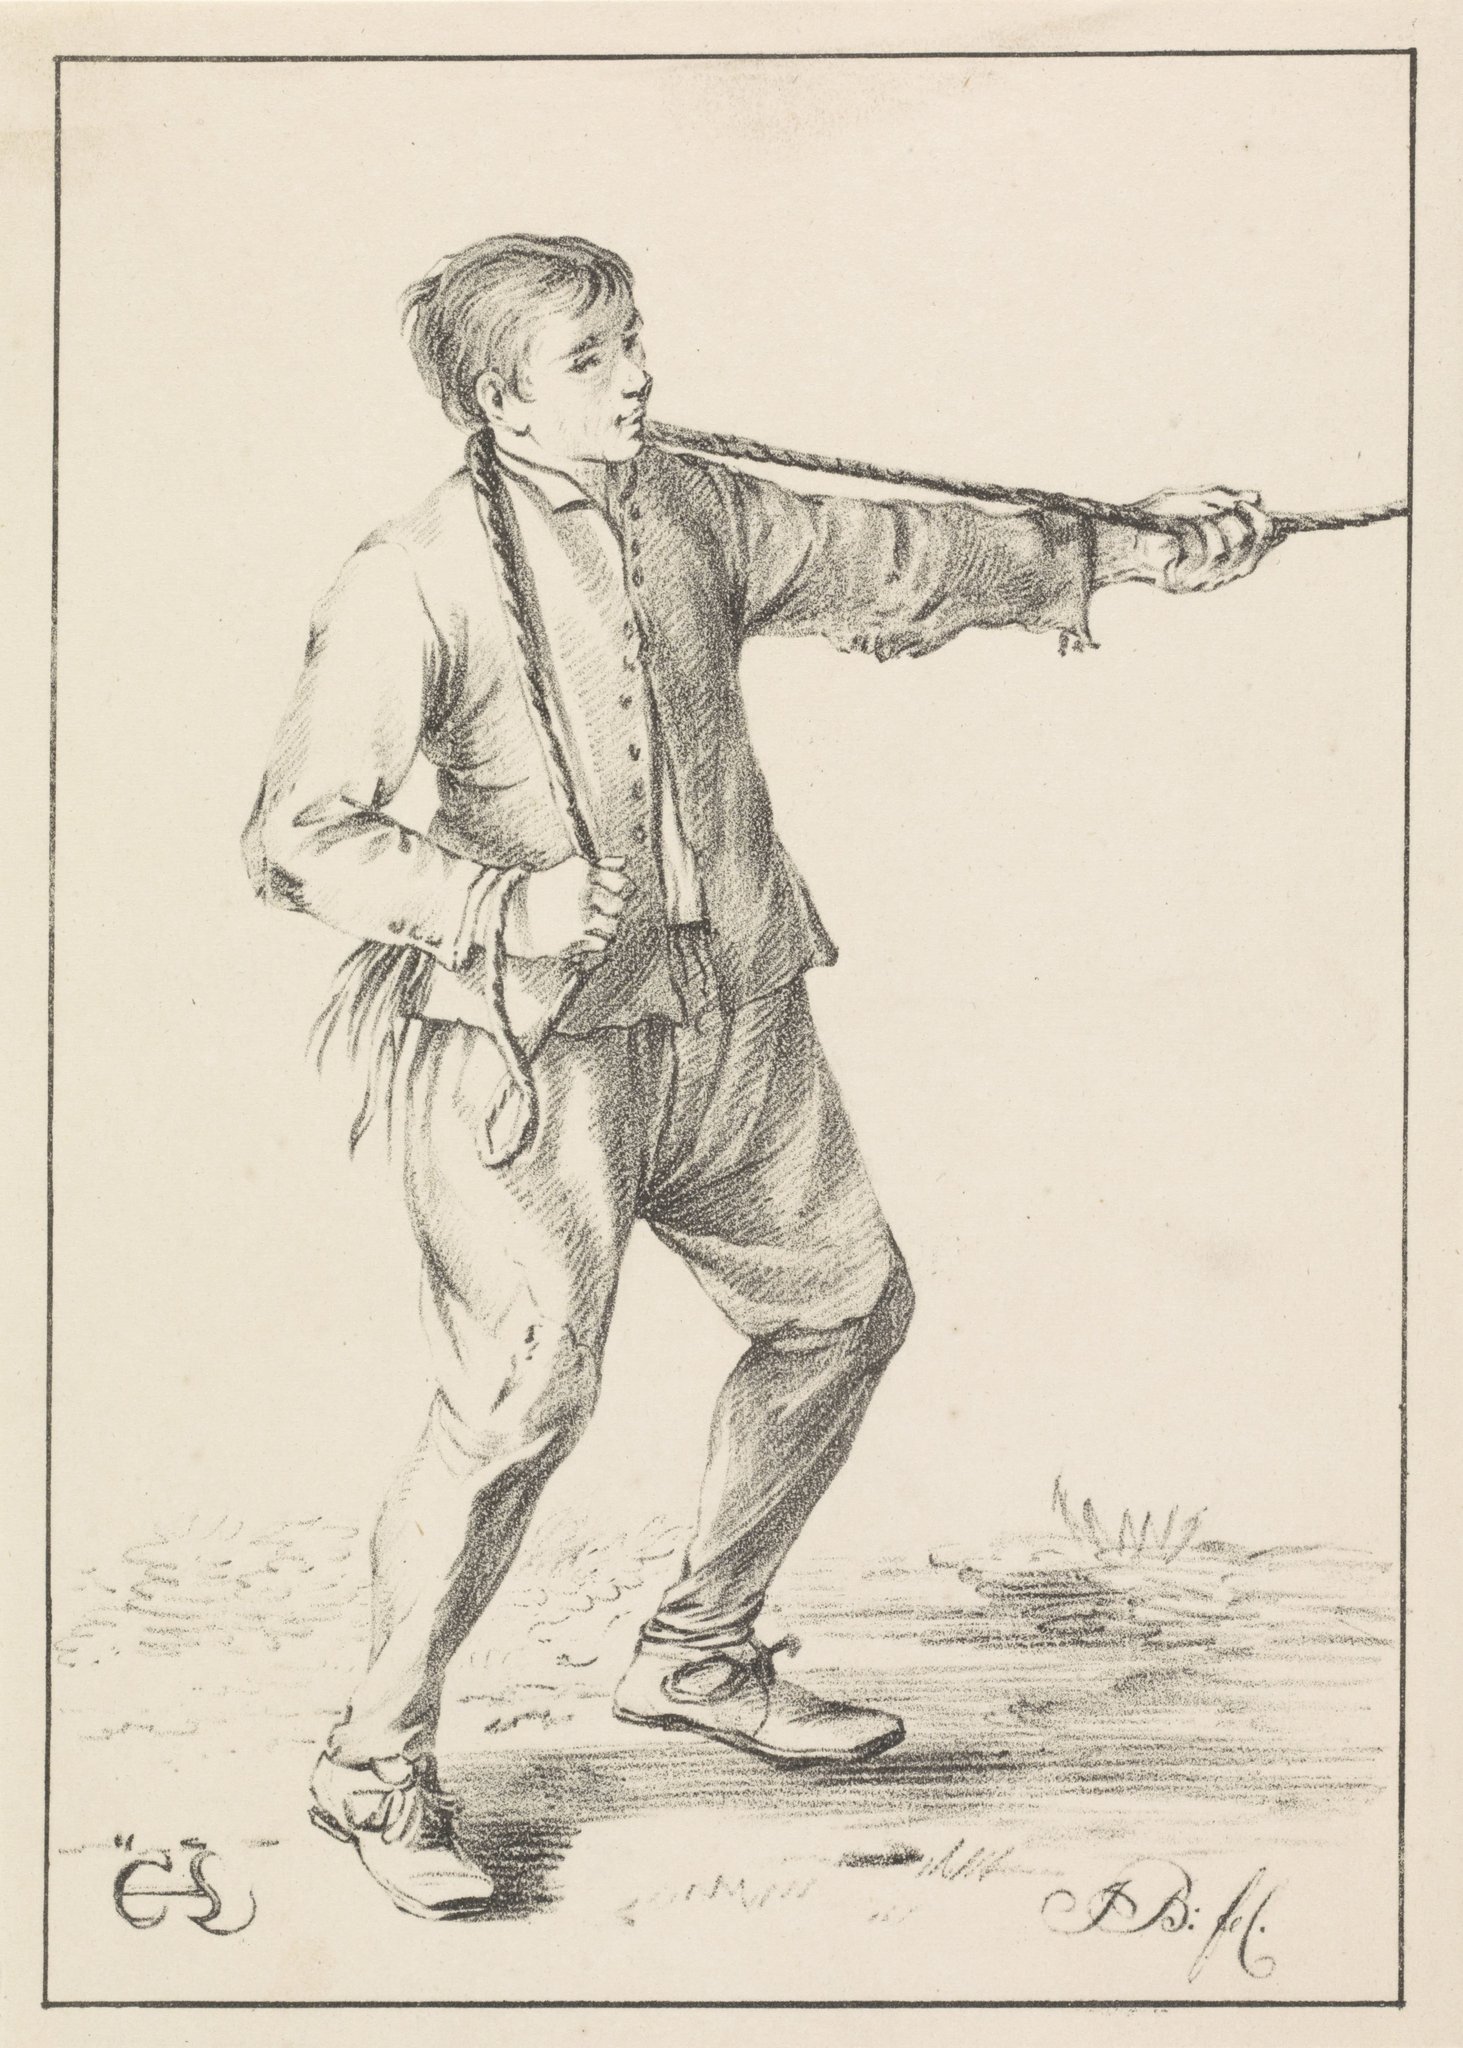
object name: print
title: Jongen aan een touw trekkend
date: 1809-1841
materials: paper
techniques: lithograph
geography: netherlands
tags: youth, adolescent, tools, aids, implements ~ crafts and industries: rope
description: De jongen heeft het touw achter zijn nek gelegd en houdt het uiteinde in zijn rechterhand. Met zijn uitgestrekte linkerarm trekt hij aan het touw.